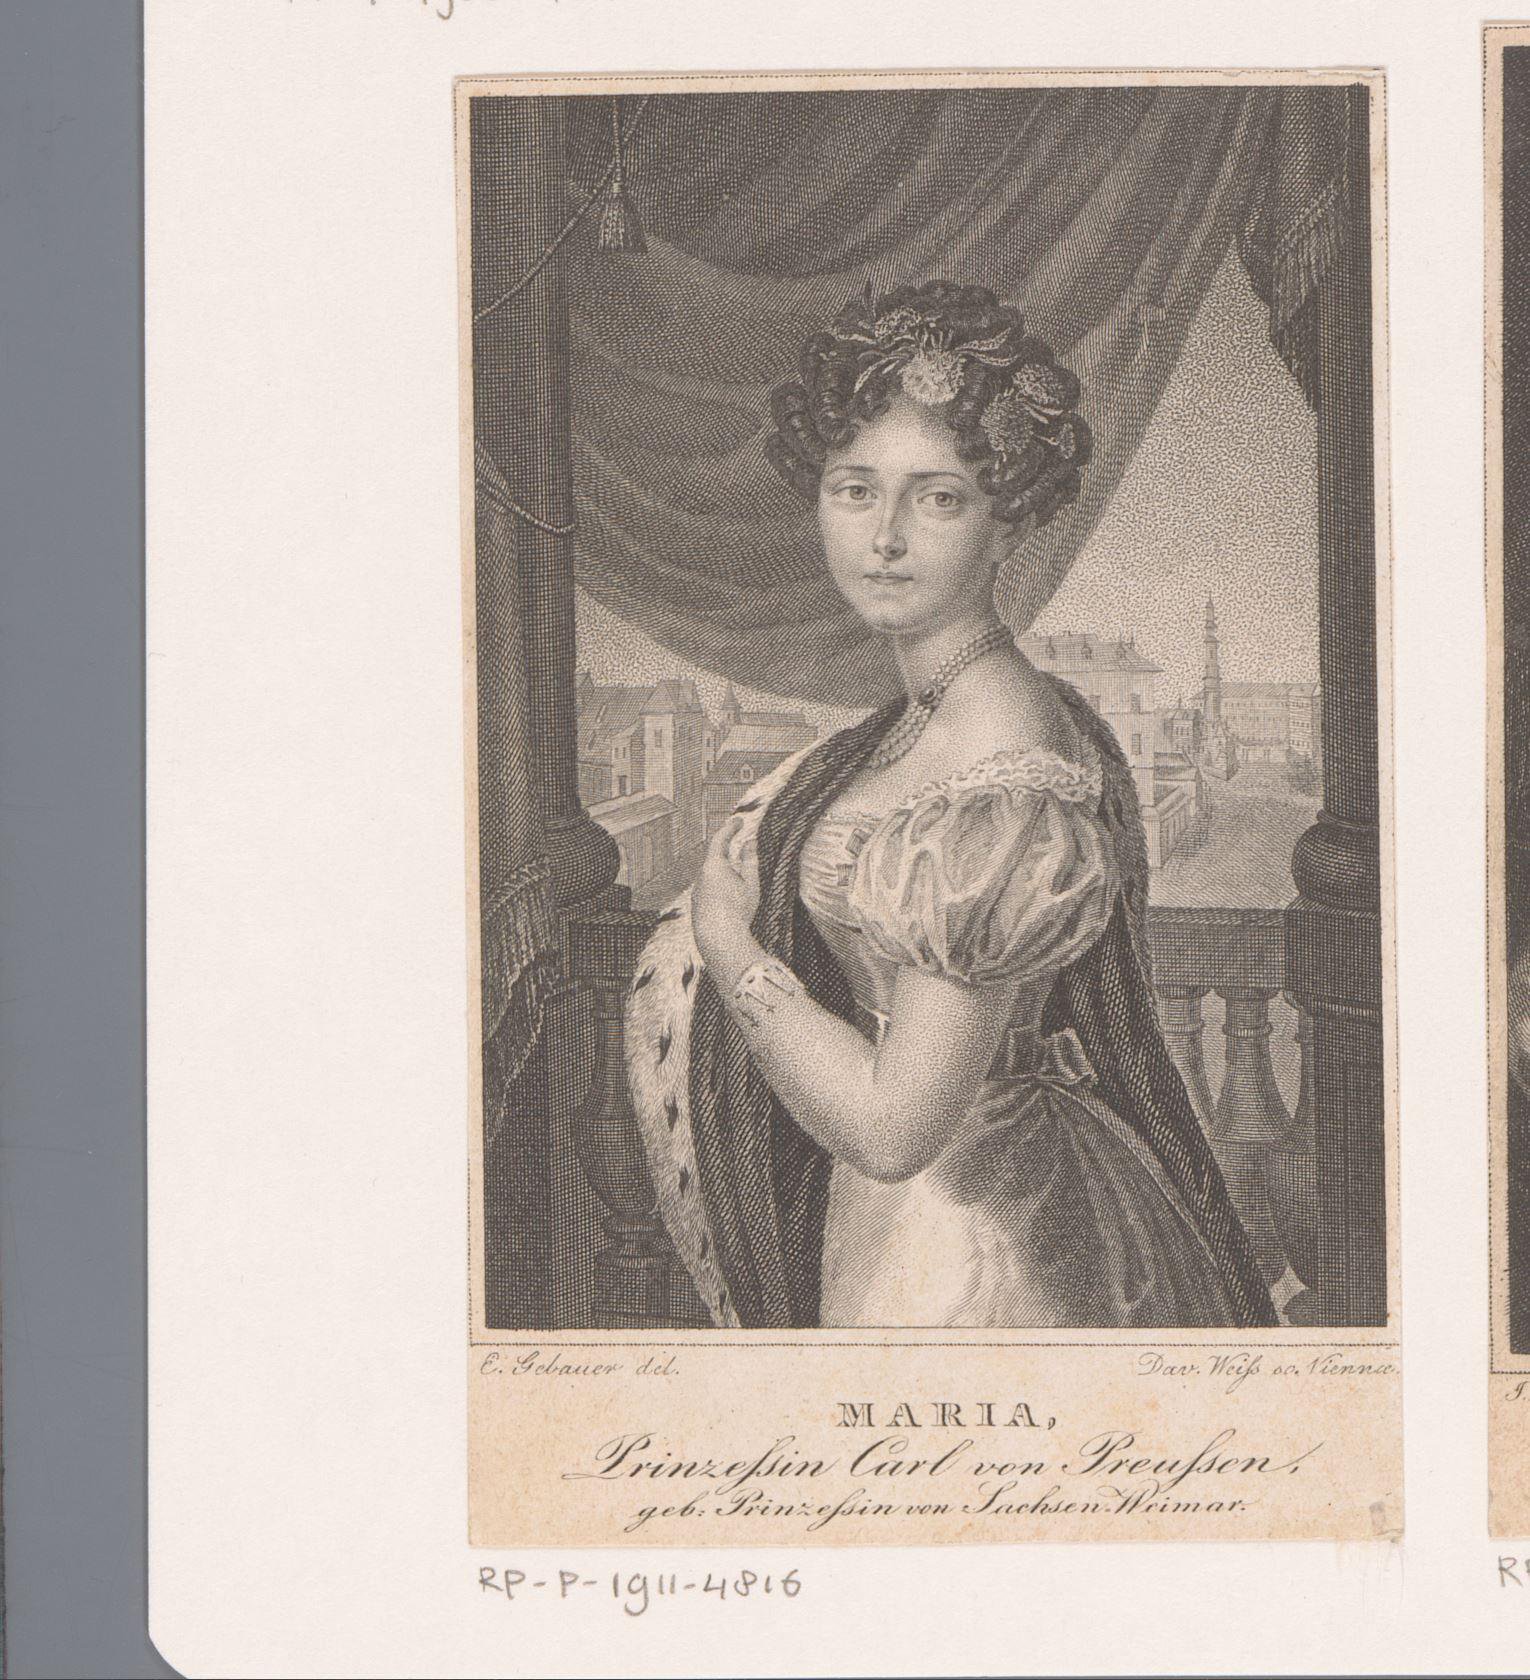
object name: print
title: Portret van Marie, prinses van Pruisen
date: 1824-1846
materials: paper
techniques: engraving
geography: vienna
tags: historical persons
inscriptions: collector's mark: Lugt 2228